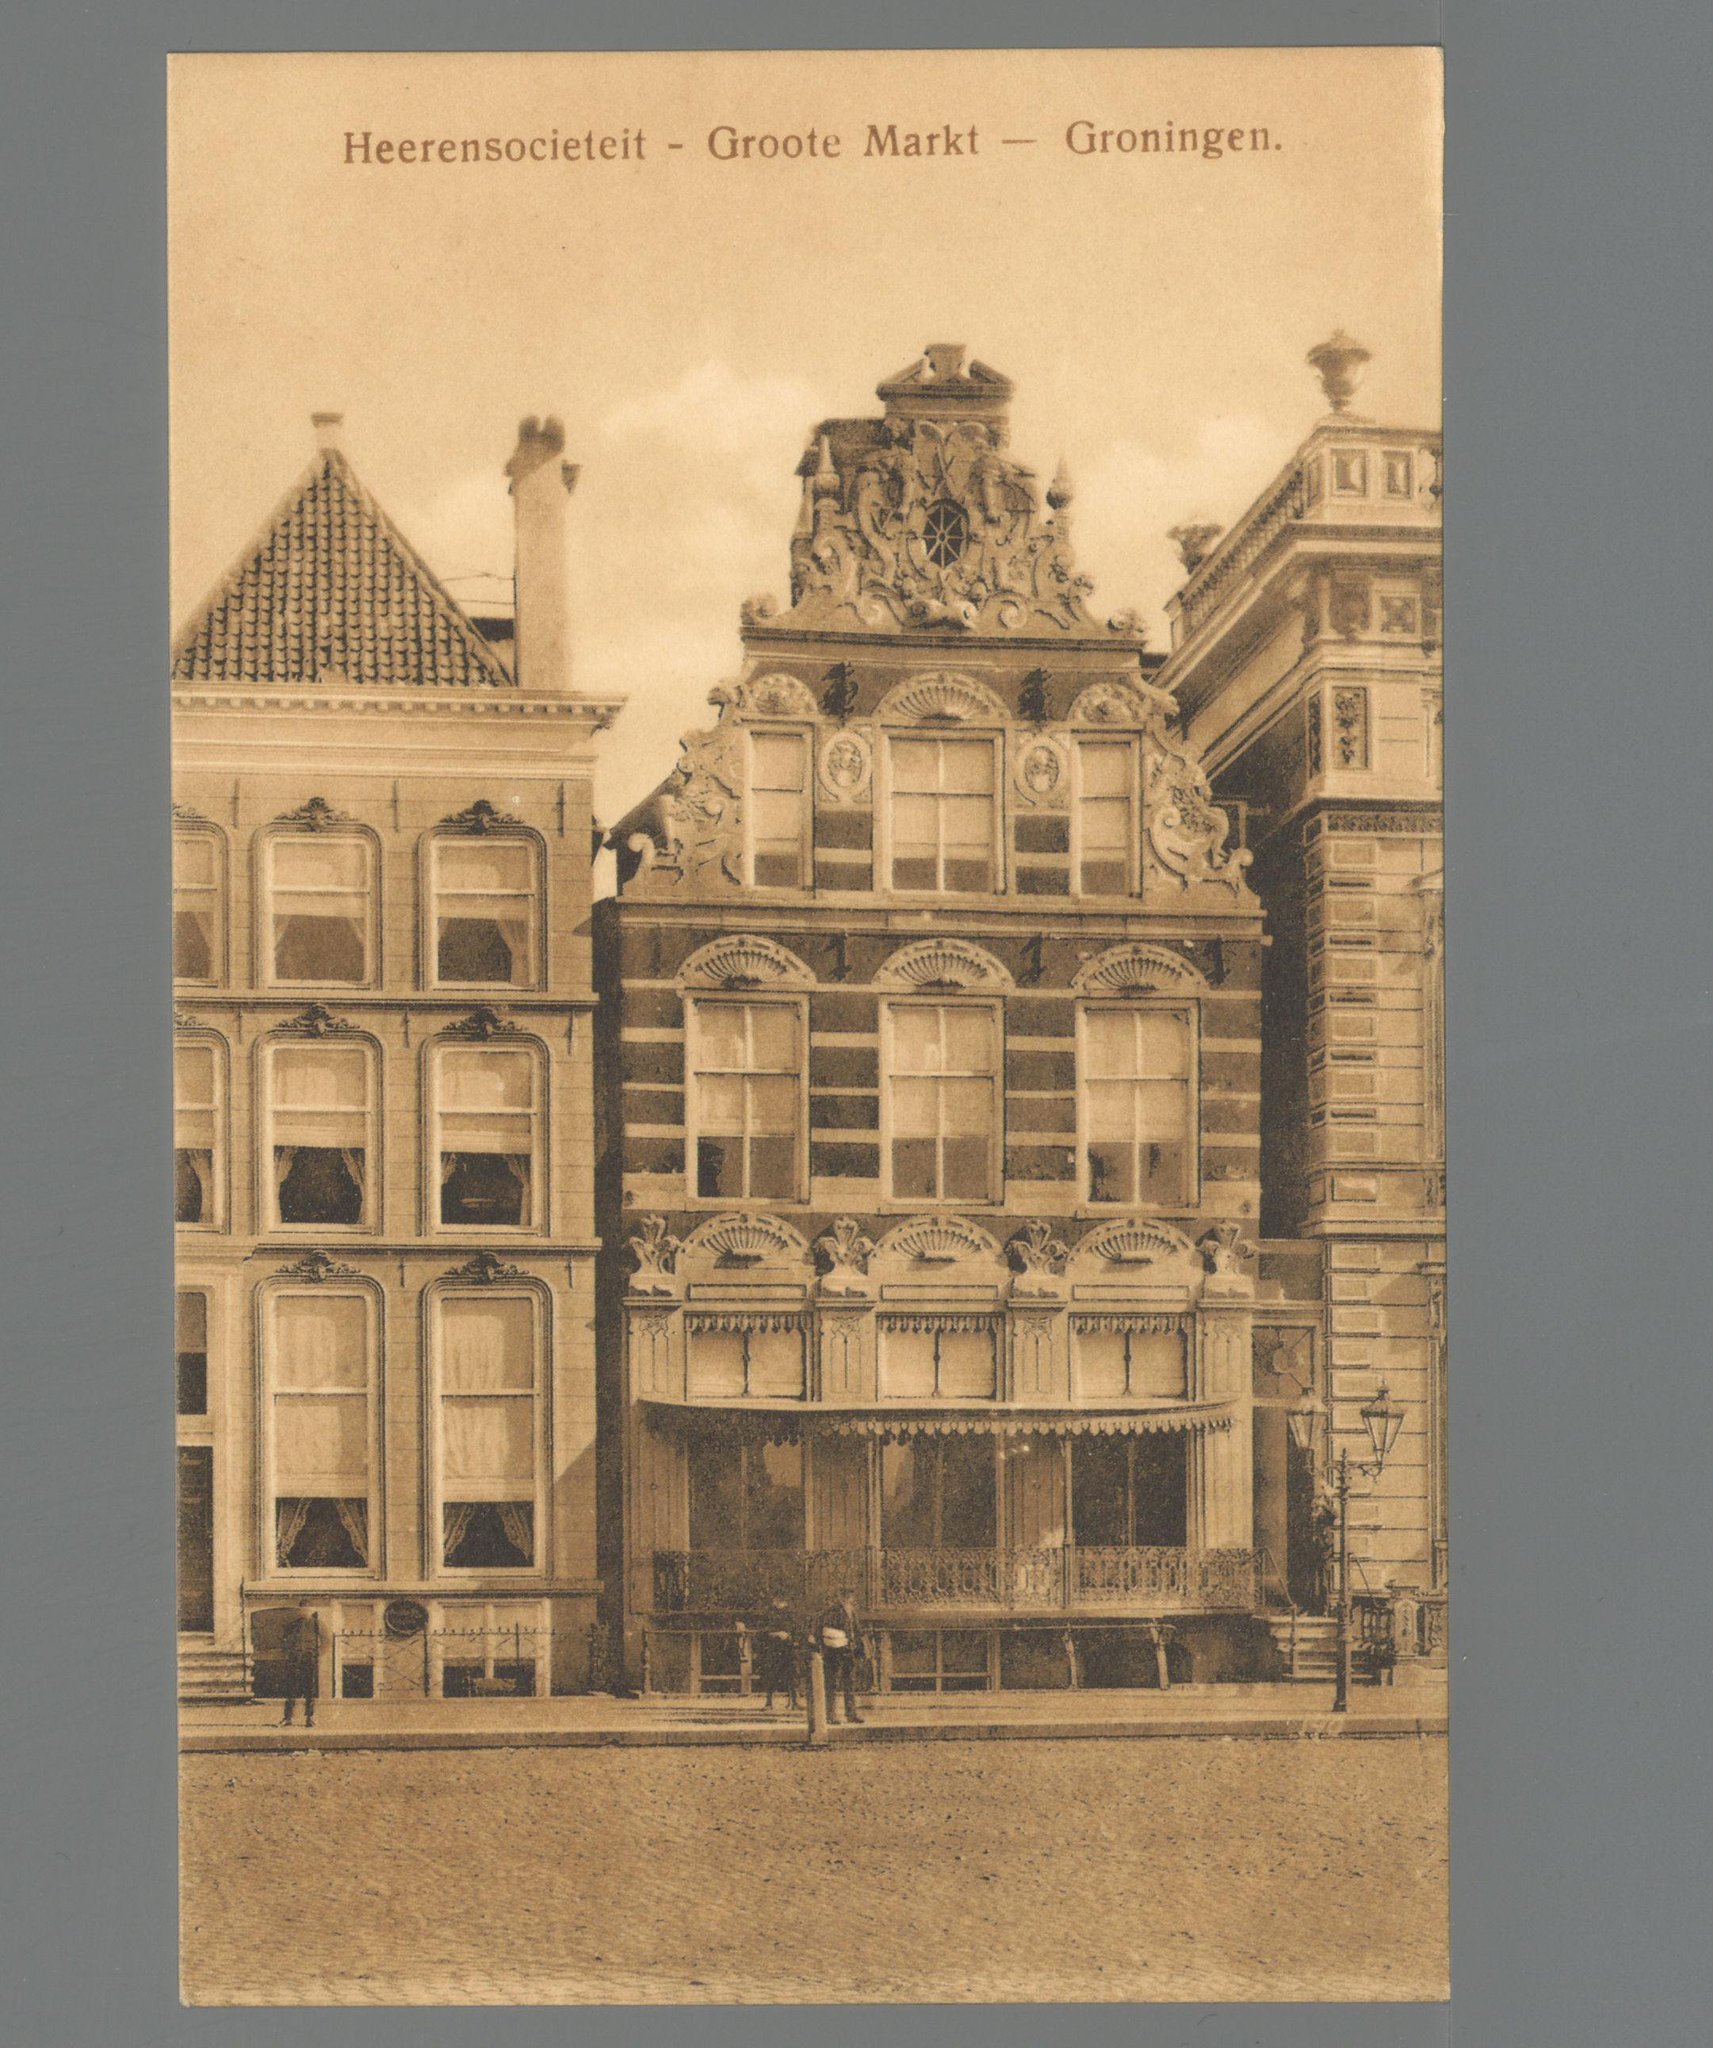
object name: photomechanical print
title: Heerensocieteit - Groote Markt - Groningen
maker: Anonymous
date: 1905-1930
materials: cardboard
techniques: photograph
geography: zwolle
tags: square, place, circus, etc., façade (of house or building)